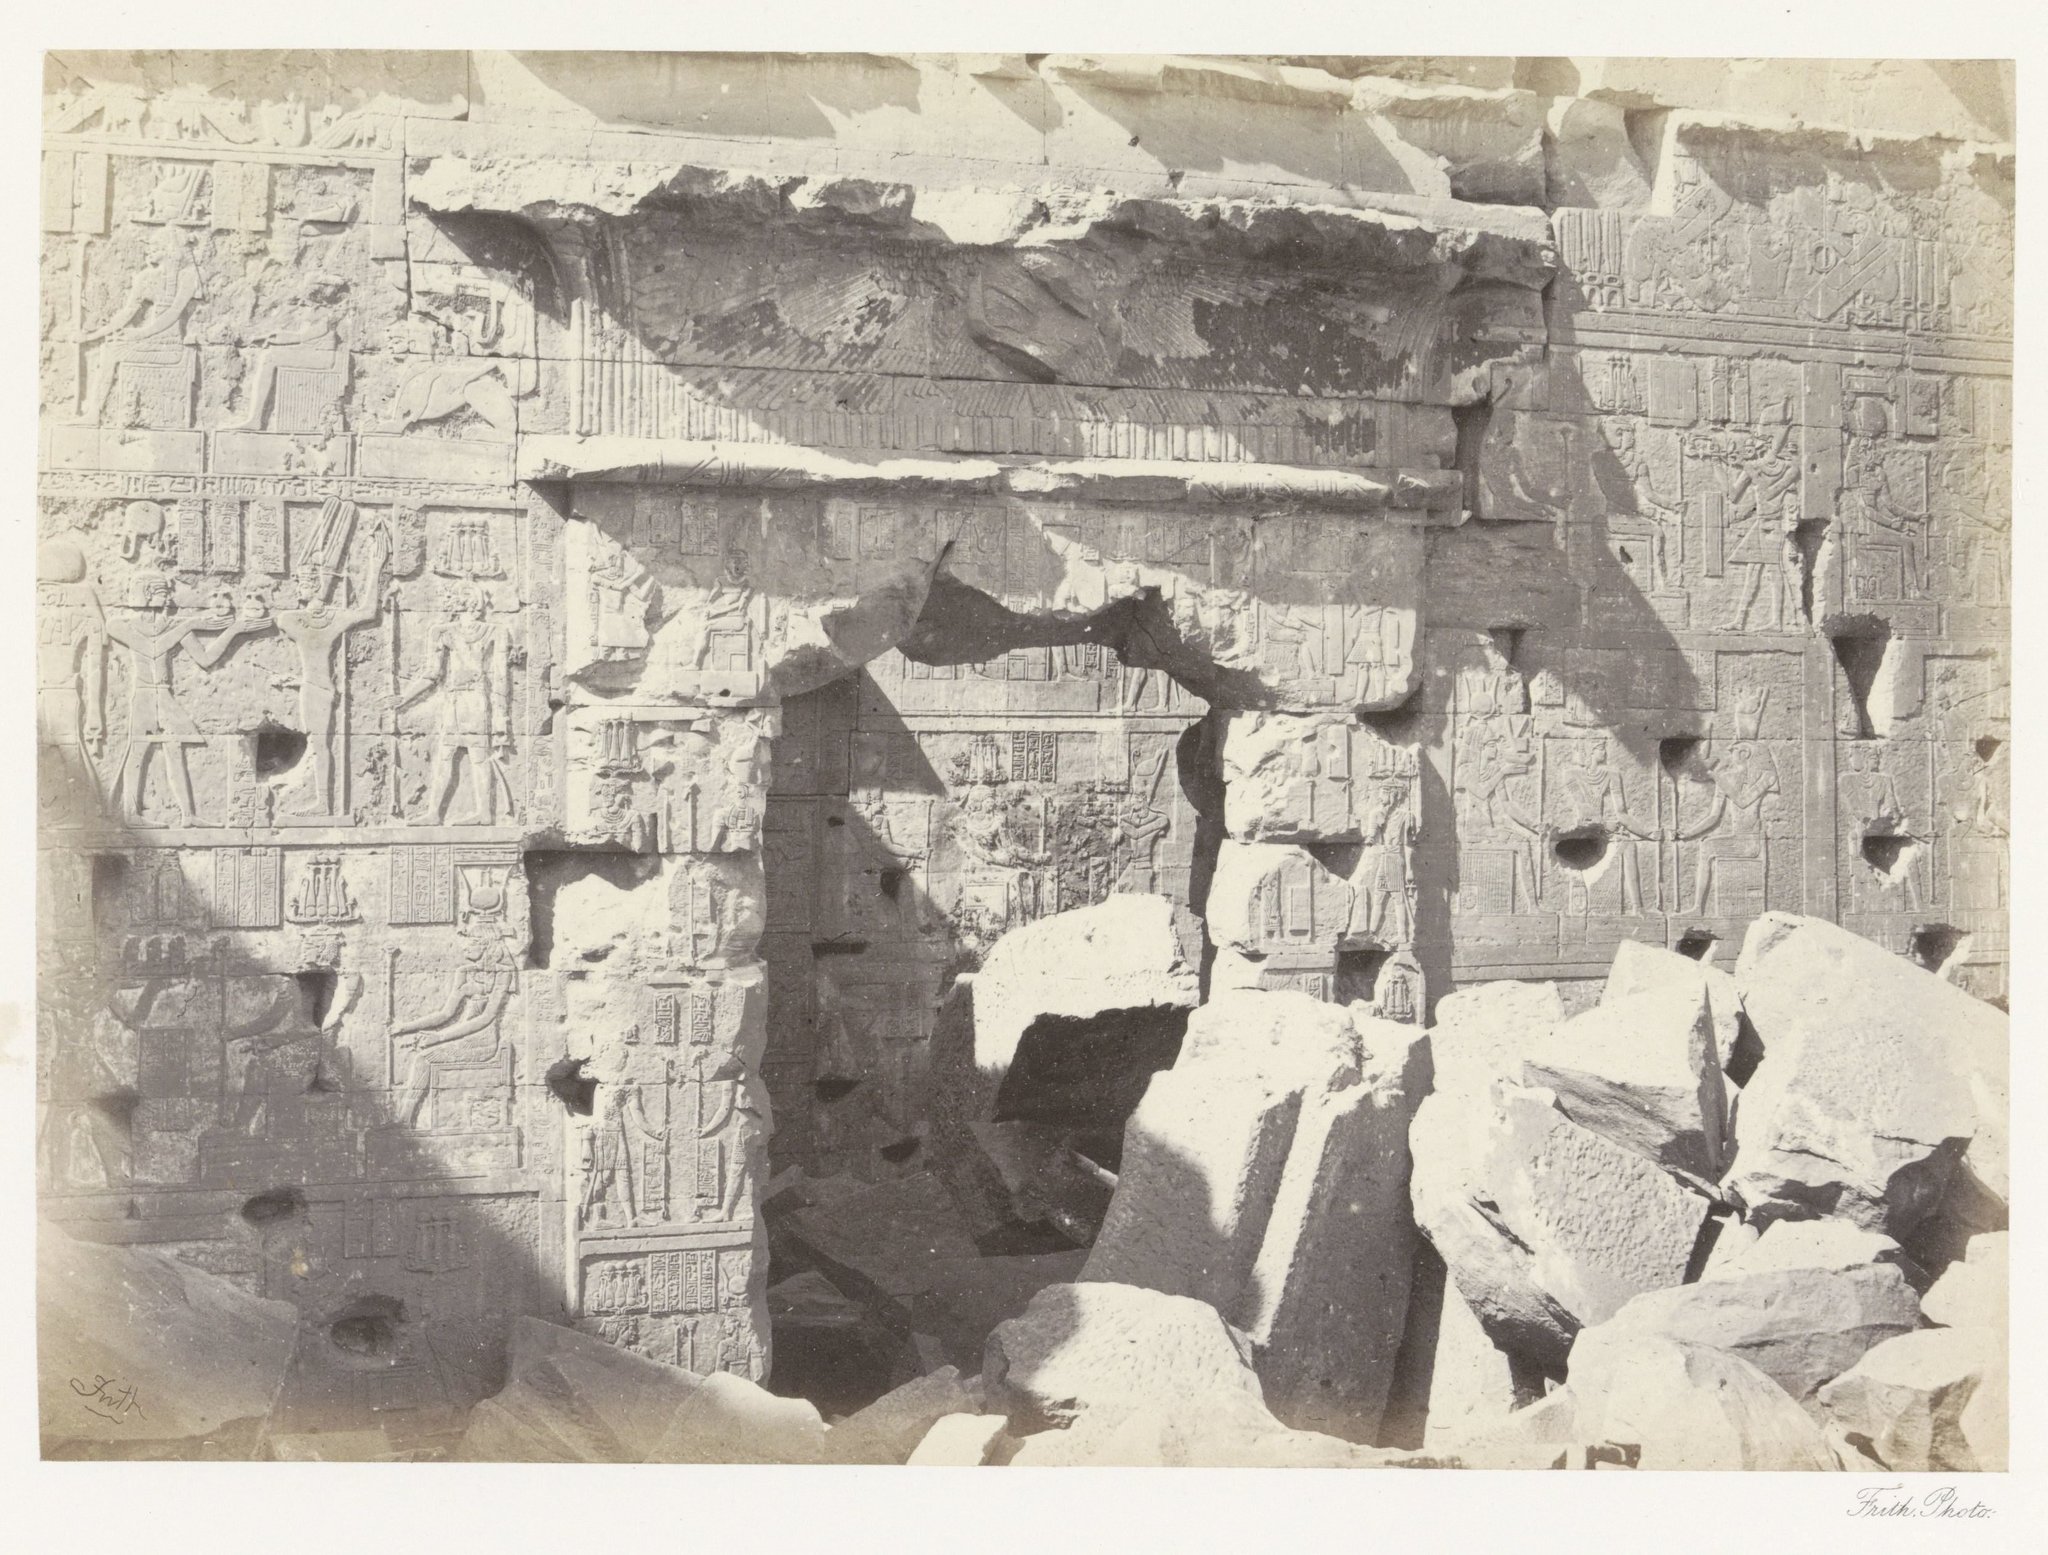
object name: photograph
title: Poort naar de tempel van Kalabsja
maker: francis frith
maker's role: publisher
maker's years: 1822-1898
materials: paper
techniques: albumen print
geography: kalabsja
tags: temple, shrine ~ egyptian religion, gate, entrance